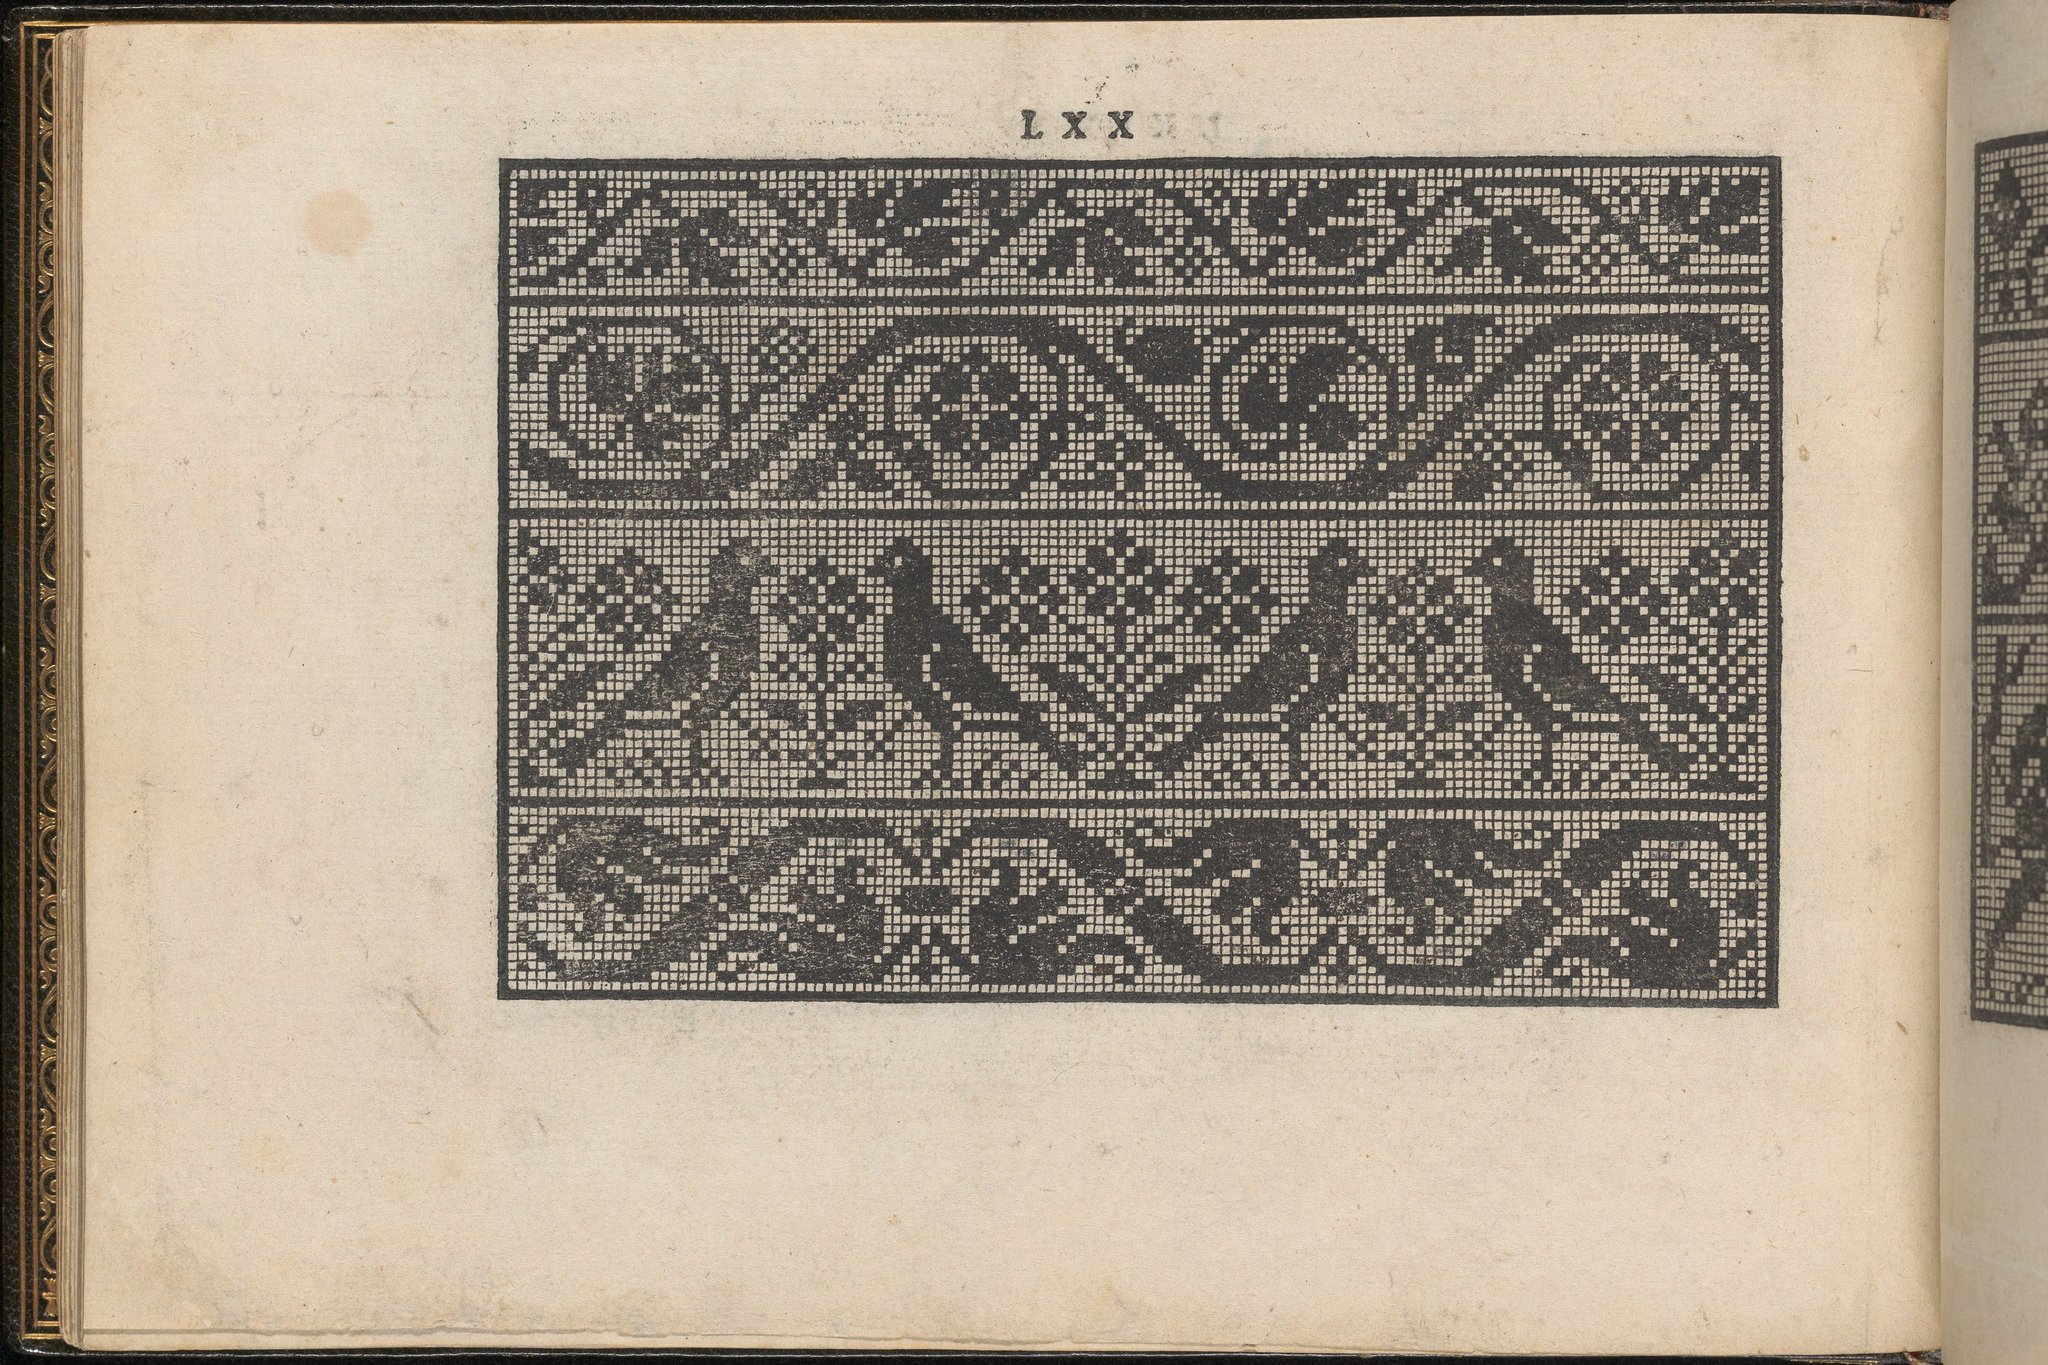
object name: book print ornament architecture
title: La Vera Perfettione del Disegno di varie sorti di recami, page 35 (verso)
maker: giovanni ostaus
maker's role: publisher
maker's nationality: italian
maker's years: 1507-1607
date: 1567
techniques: woodcut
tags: birds,flowers